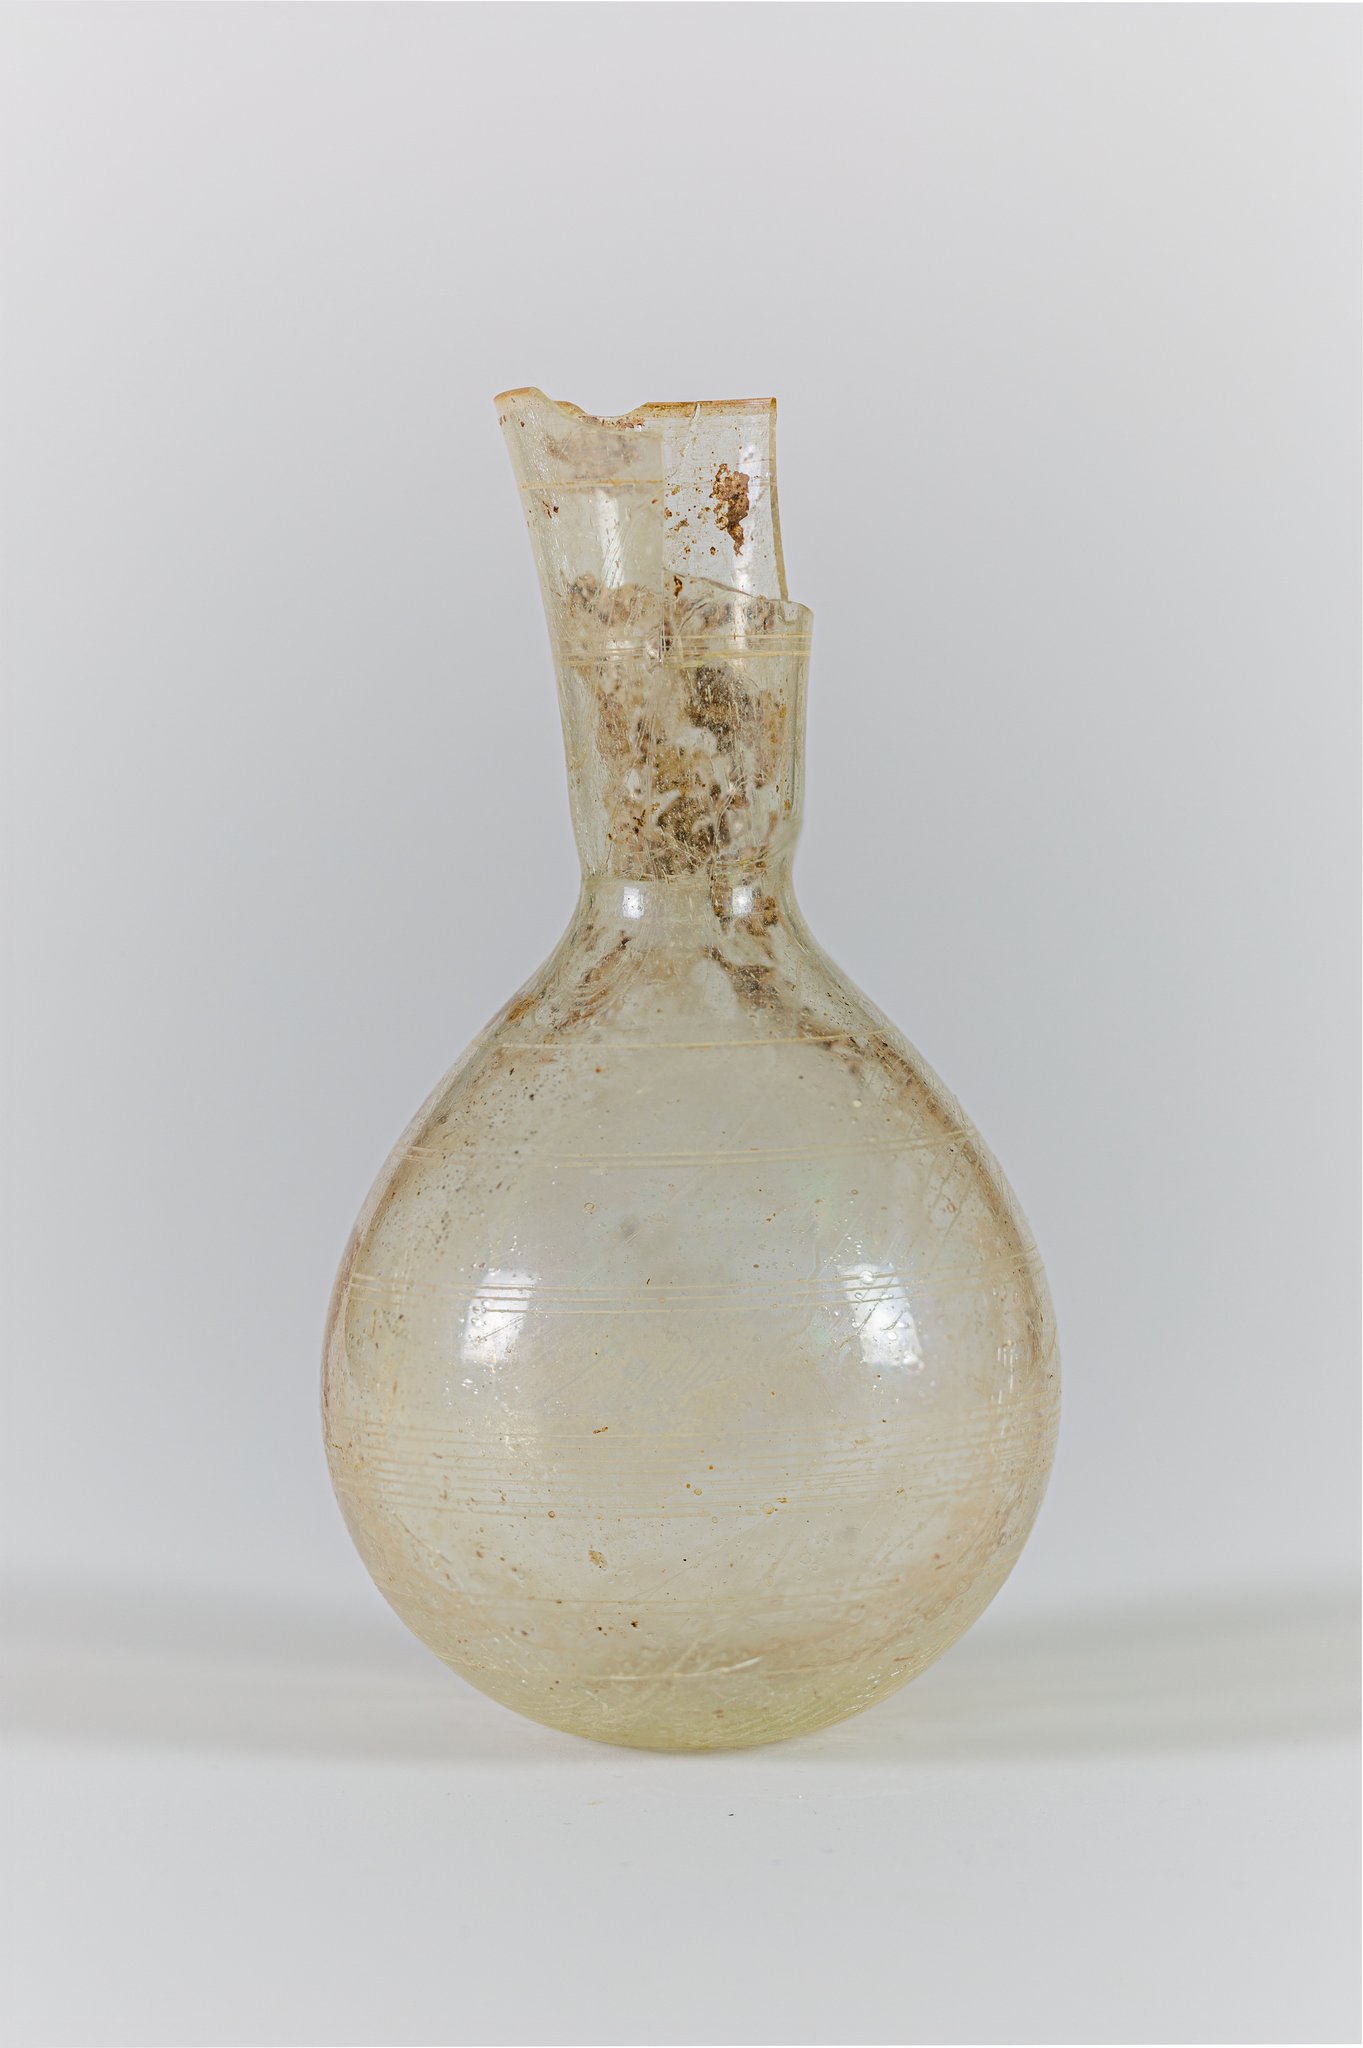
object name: flask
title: Glass flask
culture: roman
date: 201-300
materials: glass